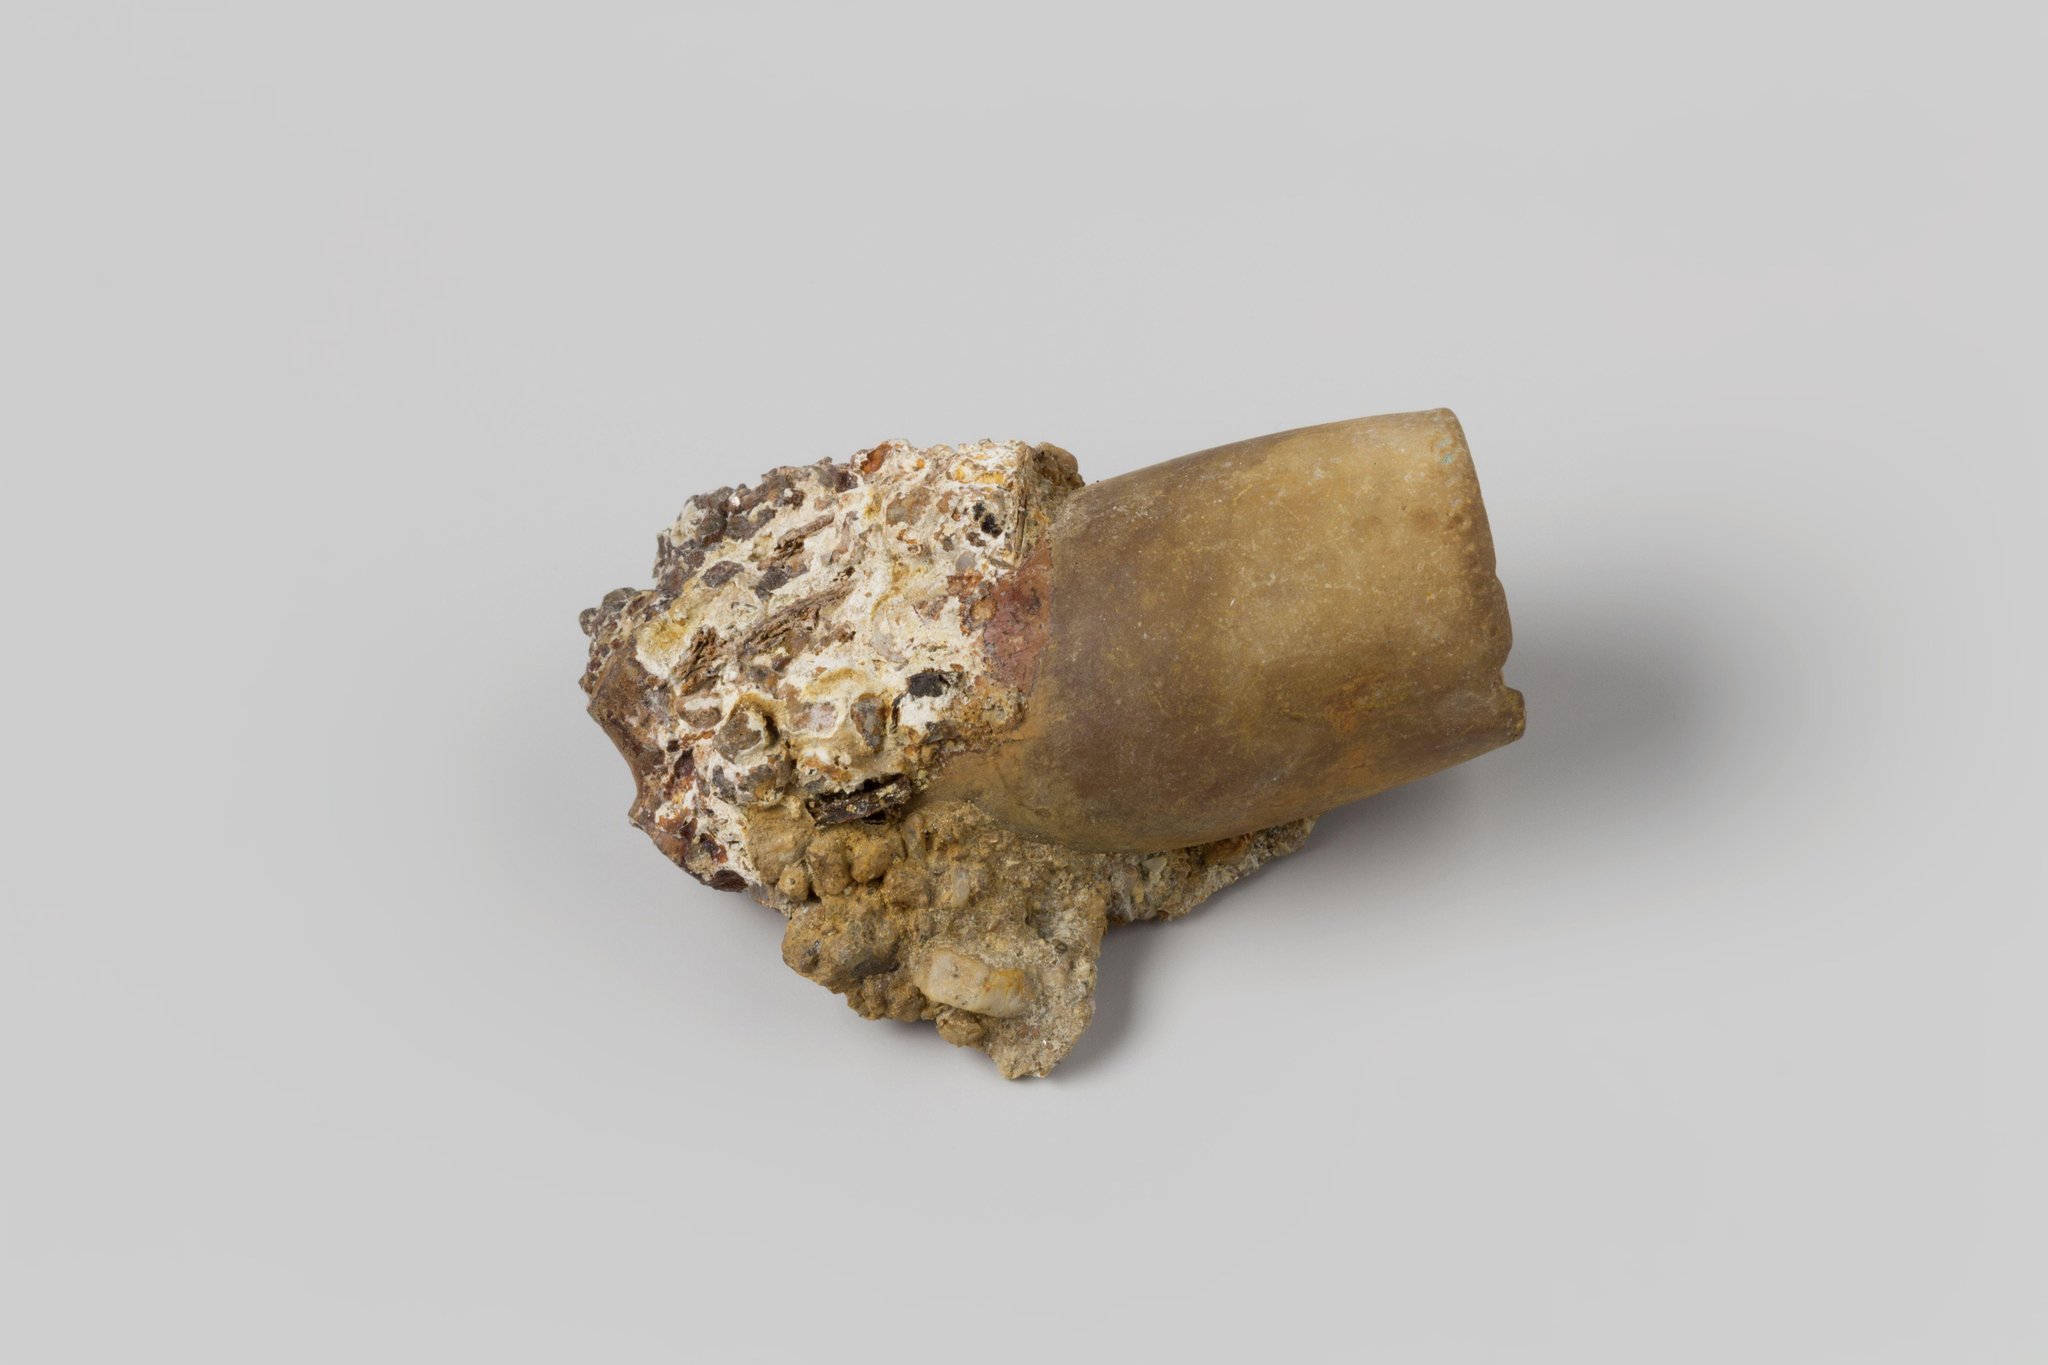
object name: pipe bowl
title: Pijpenkop in concretie uit het wrak van de Oost-Indiëvaarder Hollandia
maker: Anonymous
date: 1700-1743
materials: stone, clay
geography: netherlands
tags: verenigde oostindische compagnie, hollandia (schip), annet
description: Pipe, bowl, heelmark illegible; fragment, concreted.